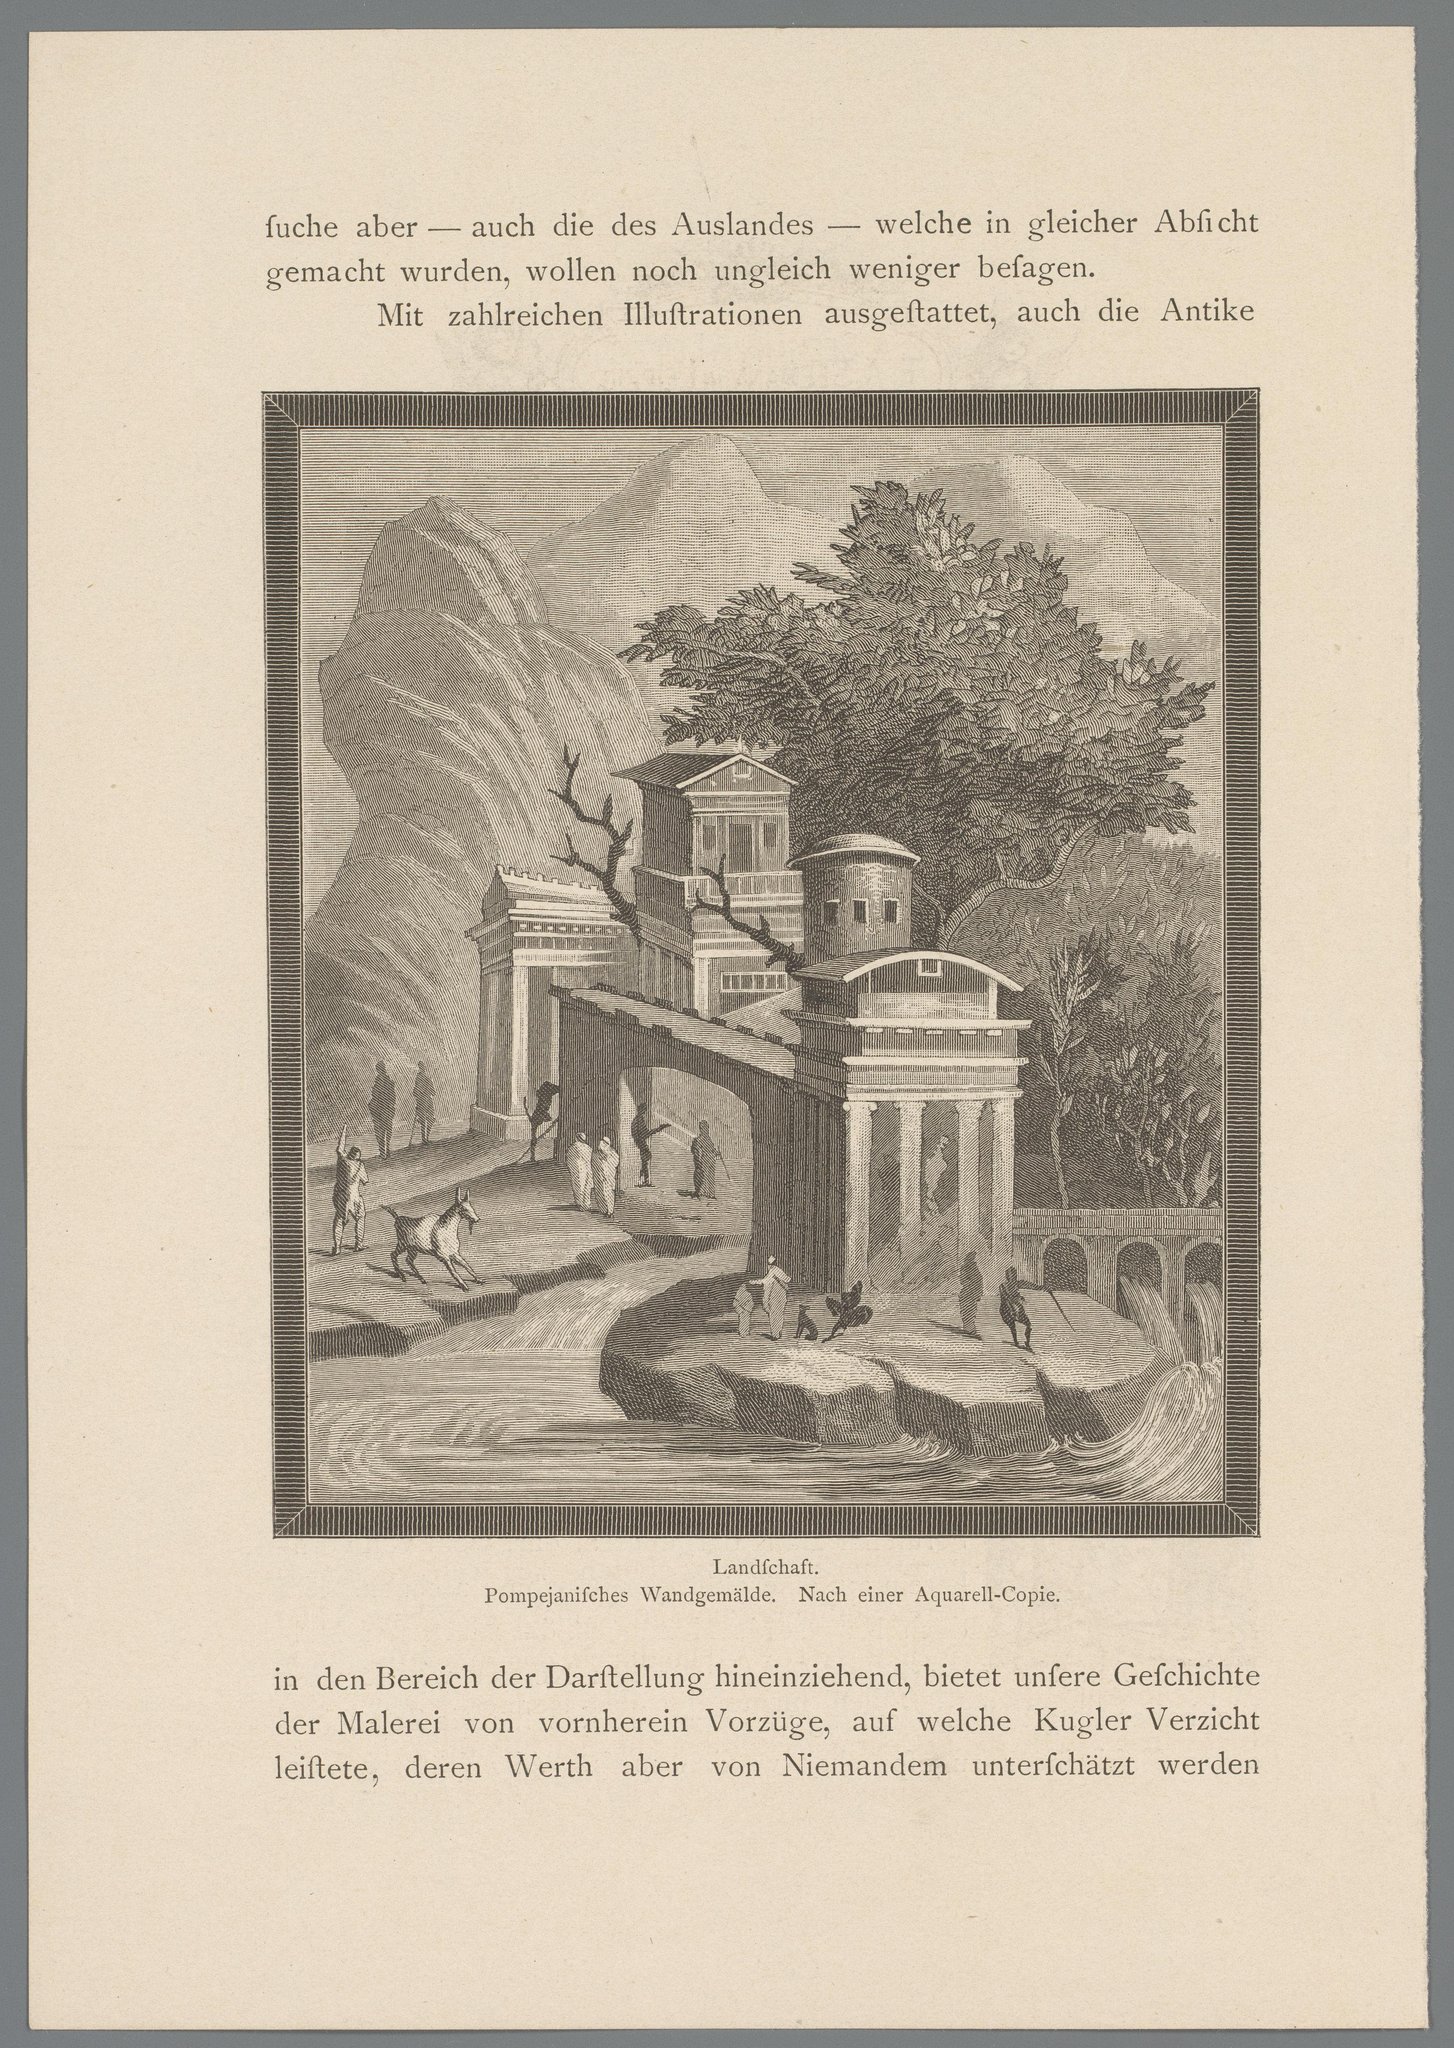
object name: reclamefolder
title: Landschaft. Pompejanisches Wandgemälde. Nach einer Aquarell-Copie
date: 1879-1916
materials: paper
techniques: letterpress printing, engraving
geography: leipzig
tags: river, landscape with bridge, viaduct or aqueduct, mountains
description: Prent op reclamefolder voor het boek 'Geschichte der Malerei' door Alfred Woltmann.